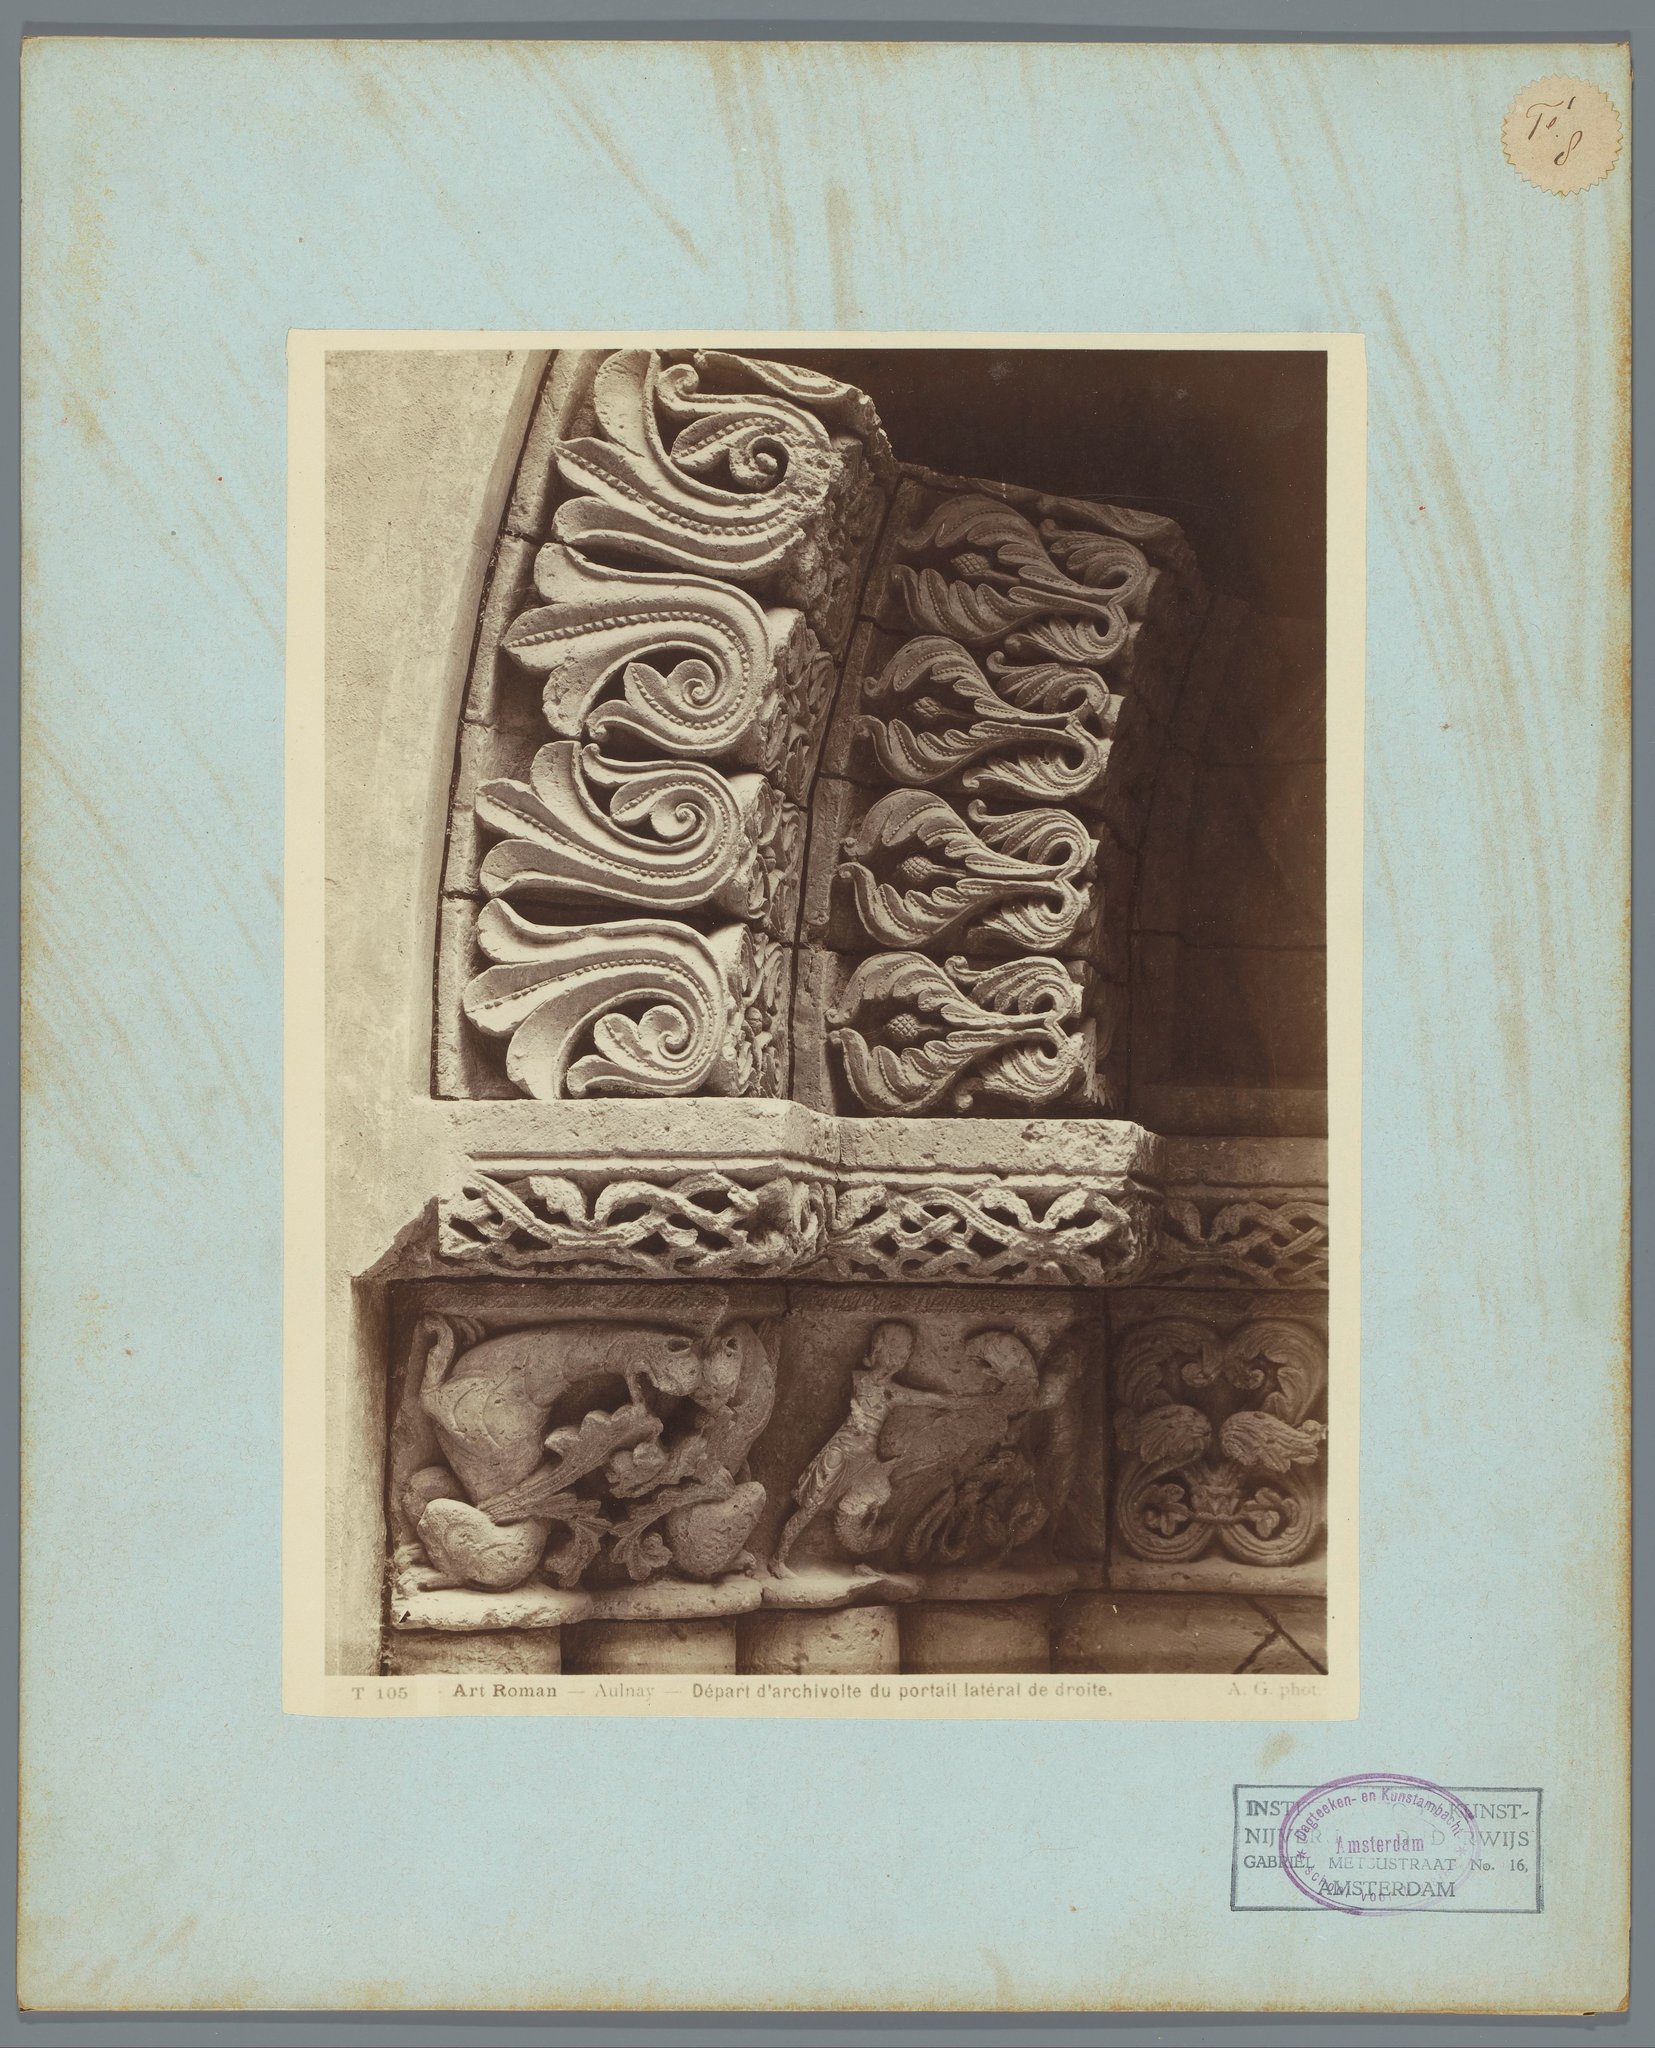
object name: photograph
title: Deel van het portaal van de Kathedraal van Aulnay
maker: adolphe giraudon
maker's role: publisher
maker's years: 1849-1929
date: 1875-1900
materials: cardboard, photographic support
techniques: albumen print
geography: paris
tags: parts of church exterior and annexes: portal, sculpture (+ relief ~ sculpture)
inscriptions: number: ‘T 105’, collector's mark: ‘INSTITUUT VOOR KUNST- NIJVERHEIDSONDERWIJS GABRIËL METSUSTRAAT No. 16. AMSTERDAM’, collector's mark: ‘Dagteeken- en Kunstambacht-School voor Meisjes’